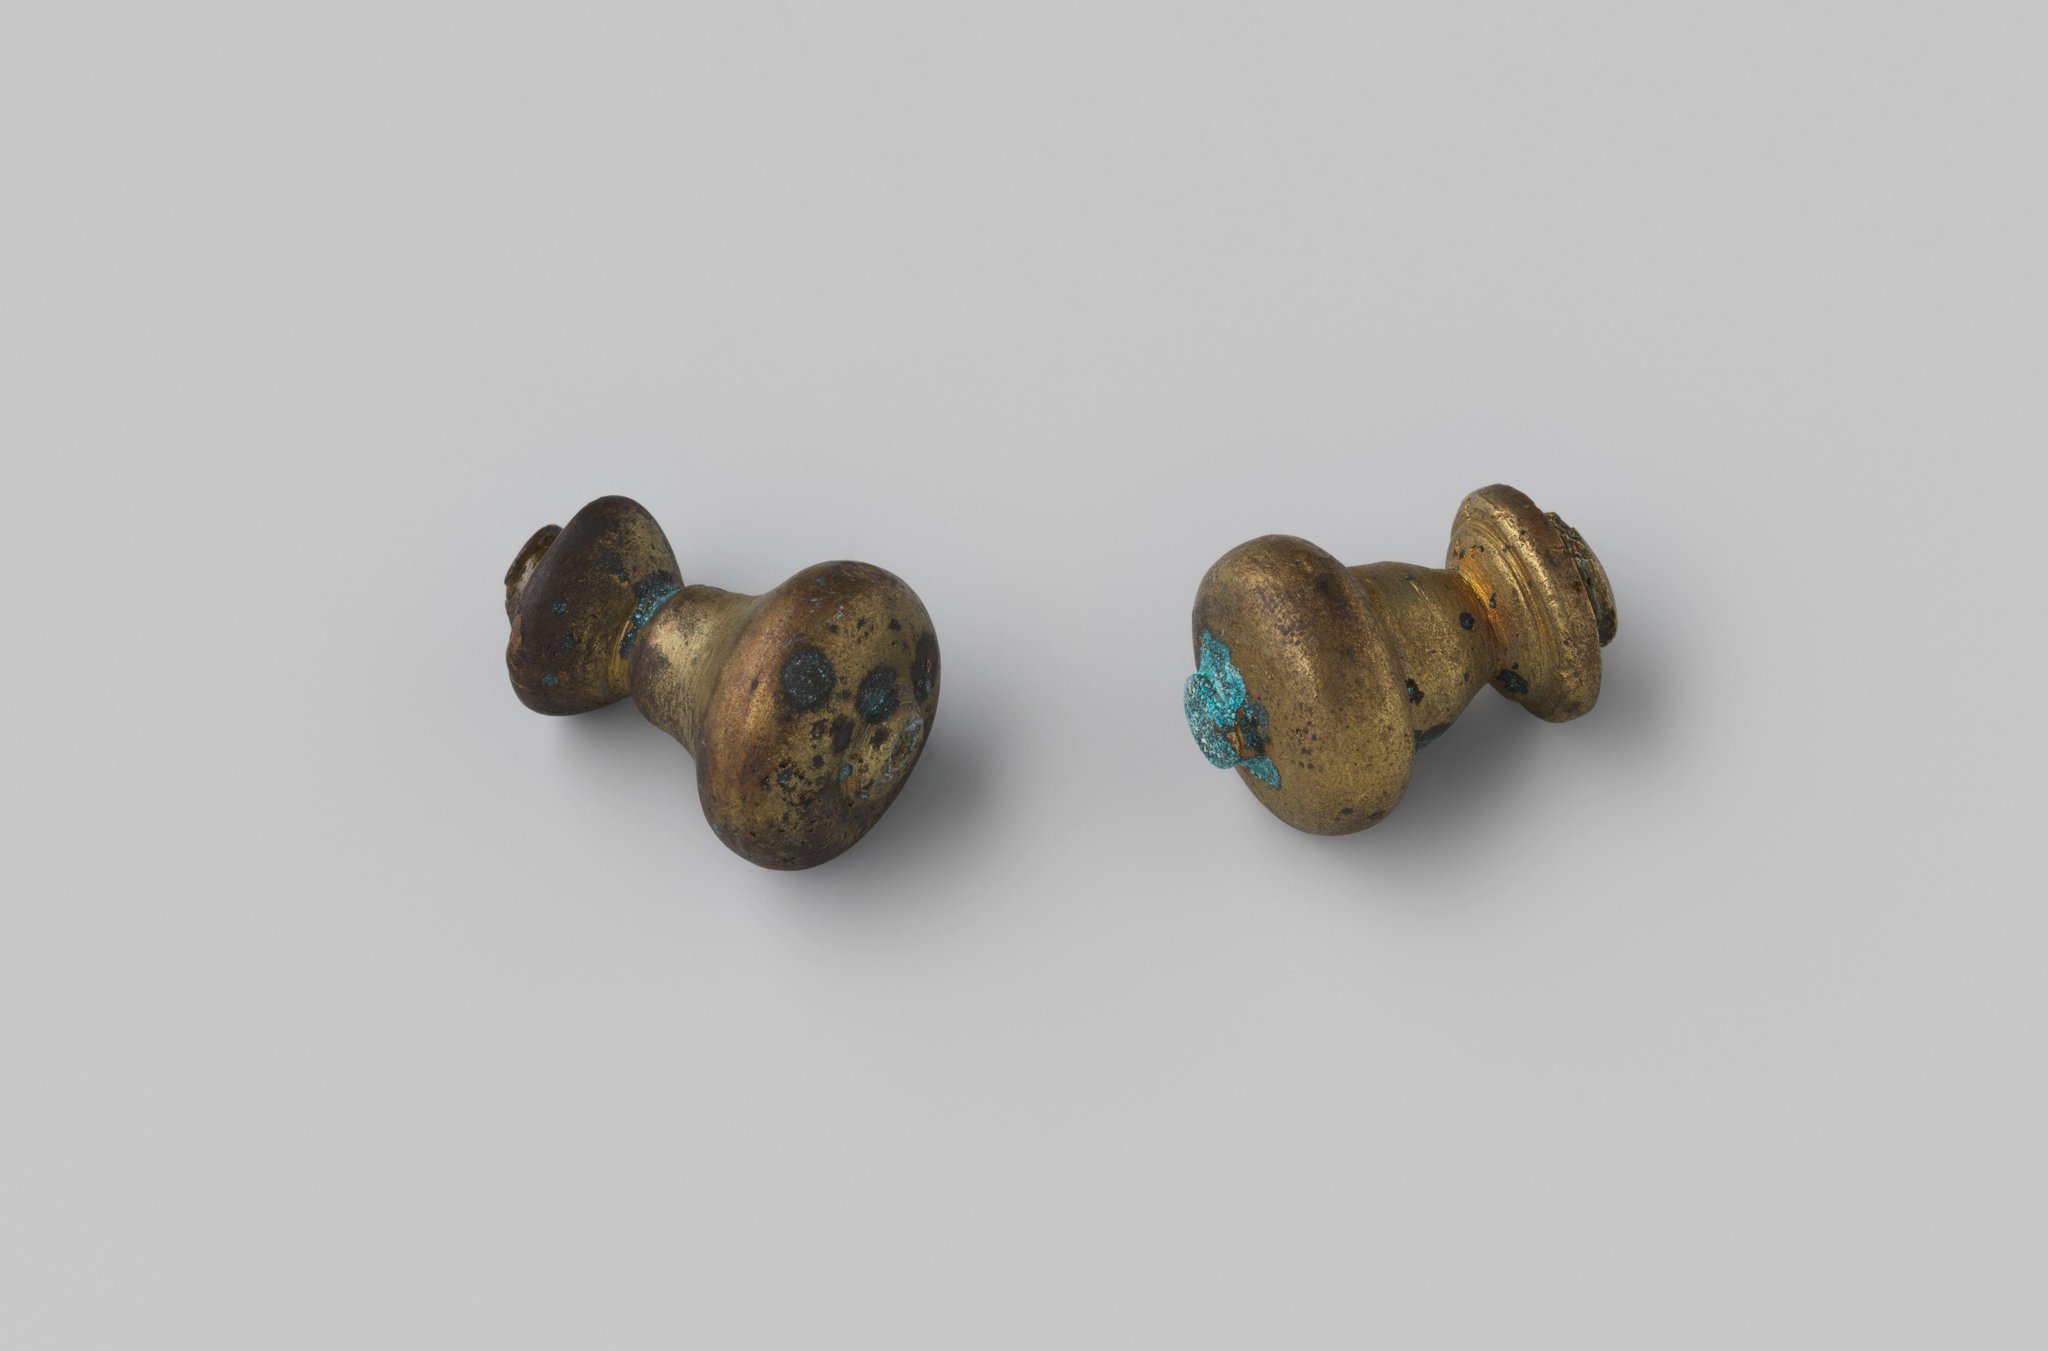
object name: knob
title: Knop uit het wrak van de Oost-Indiëvaarder Hollandia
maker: Anonymous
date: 1700-1743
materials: copper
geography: netherlands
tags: verenigde oostindische compagnie, hollandia (schip), annet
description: Fitting, knob; acorn-shaped: raised navel on top, conical base, tenon underneath flattened: short stub projecting on top, stepped base, tenon underneath flattened.